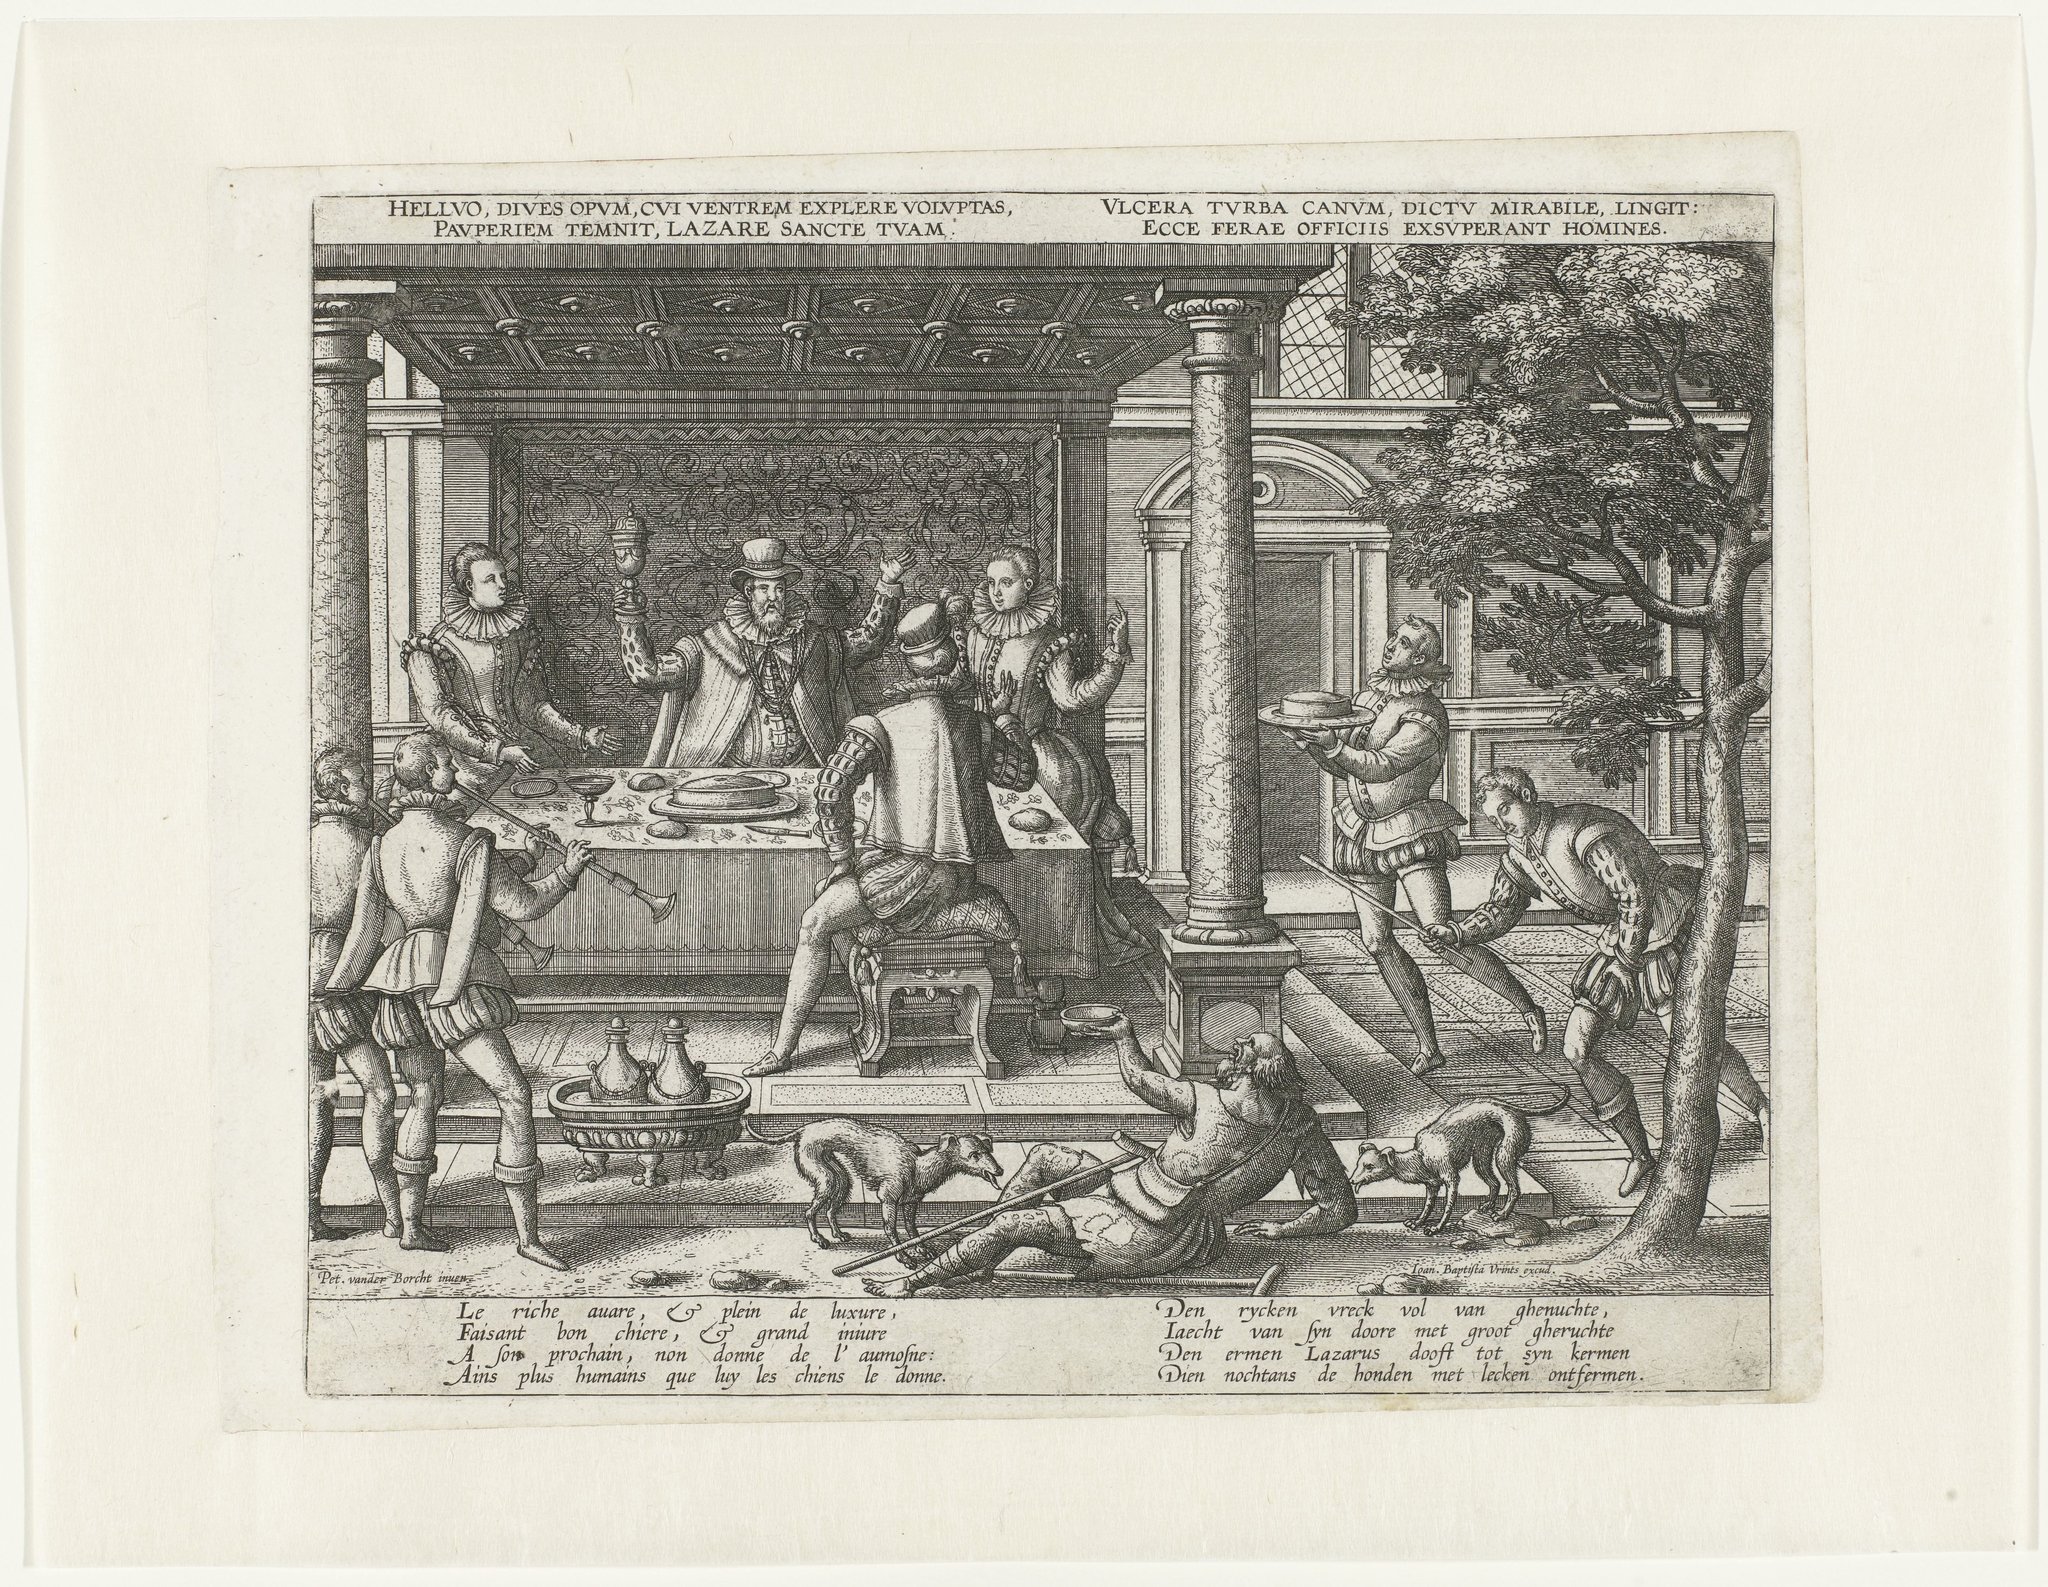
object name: print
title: Gelijkenis van de rijke man en de arme Lazarus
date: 1575-1599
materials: paper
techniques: engraving, etching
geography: antwerp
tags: cake, tart, pastry, clothes, costume (+ women's clothes), clothes, costume (+ men's clothes), the rich man (dives) is feasting, while poor lazarus is starving at the gate (dogs licking lazarus' sores) (luke 16:19-31), beggar, house personnel, servants, private festivities, merry company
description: De rijke man, met twee dames en een heer, zittend aan een banket. Rechtsvoor twee muzikanten die een blaasinstrument bespelen. Links komt een dienaar aanlopen met een pastei op een schaal. Op de voorgrond, in de tuin, ligt de arme Lazarus. Hij houdt een nap omhoog. Een hond likt zijn wonden. Met vier regels bovenschrift in het Latijn en onderschrift in het Frans en in het Nederlands.